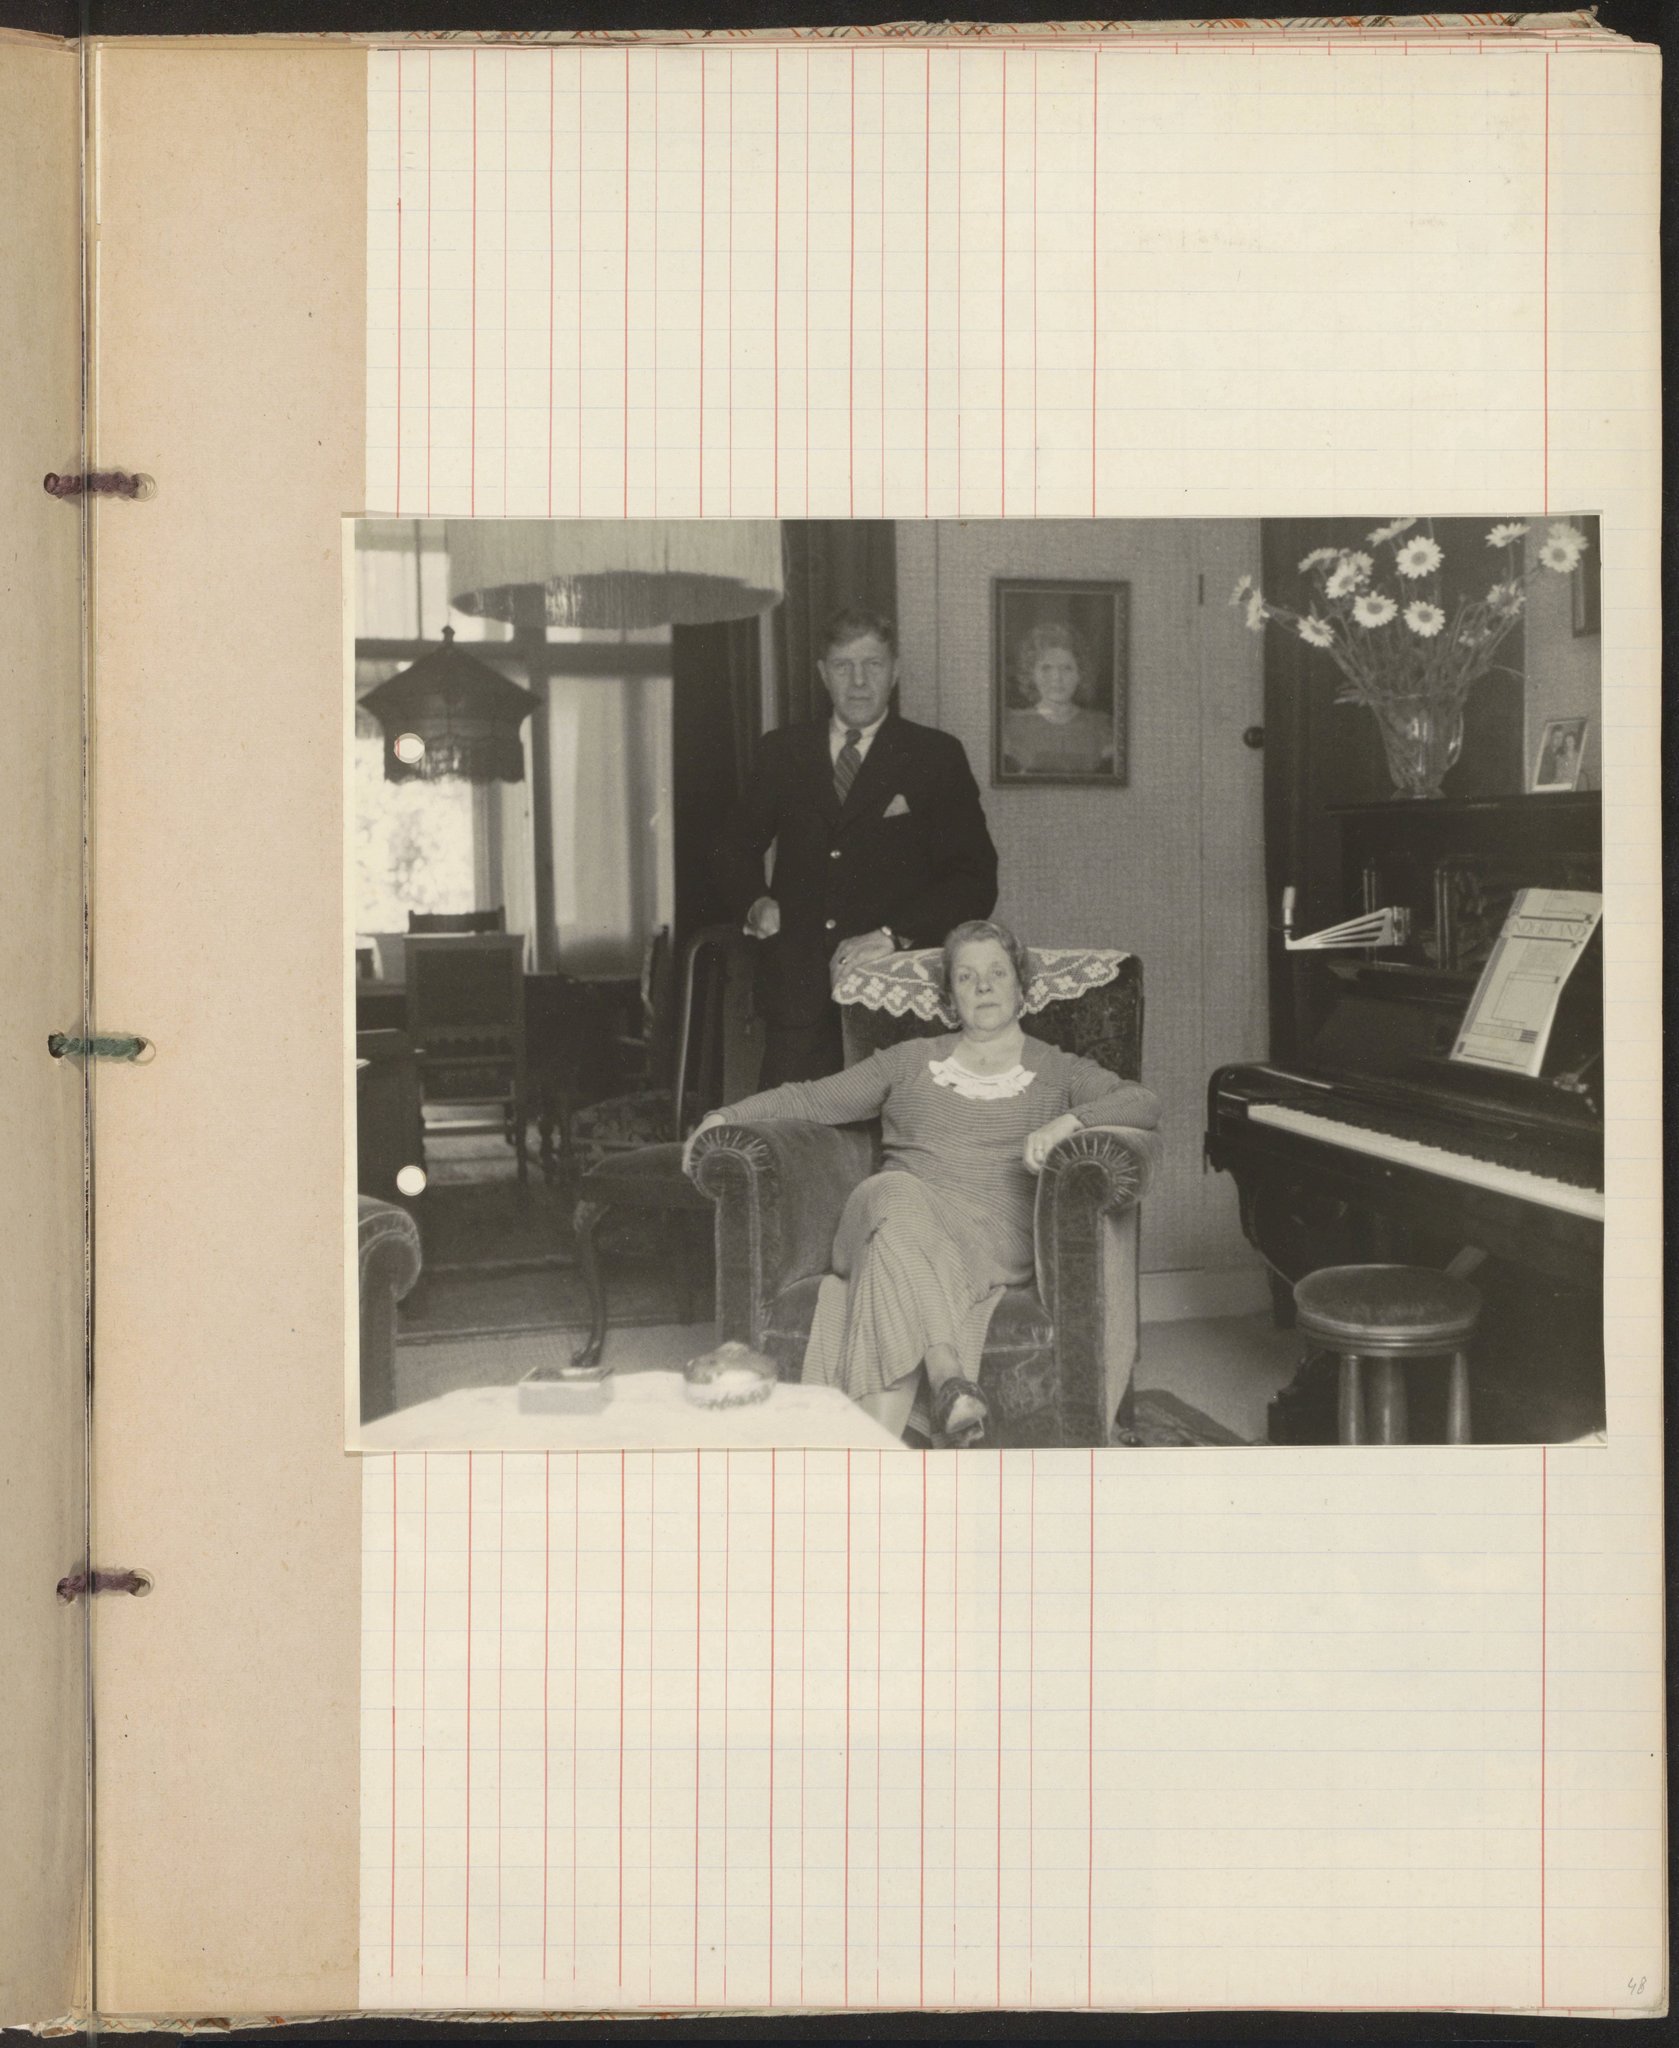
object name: photograph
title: Portret van een onbekende man en vrouw in een woonkamer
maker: Anonymous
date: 1920-1940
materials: paper, photographic support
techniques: gelatin silver print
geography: netherlands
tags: adult woman, adult man, living-room, parlour, sitting-room, pianoforte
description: Onderdeel van Fotoalbum van de familie Petri.